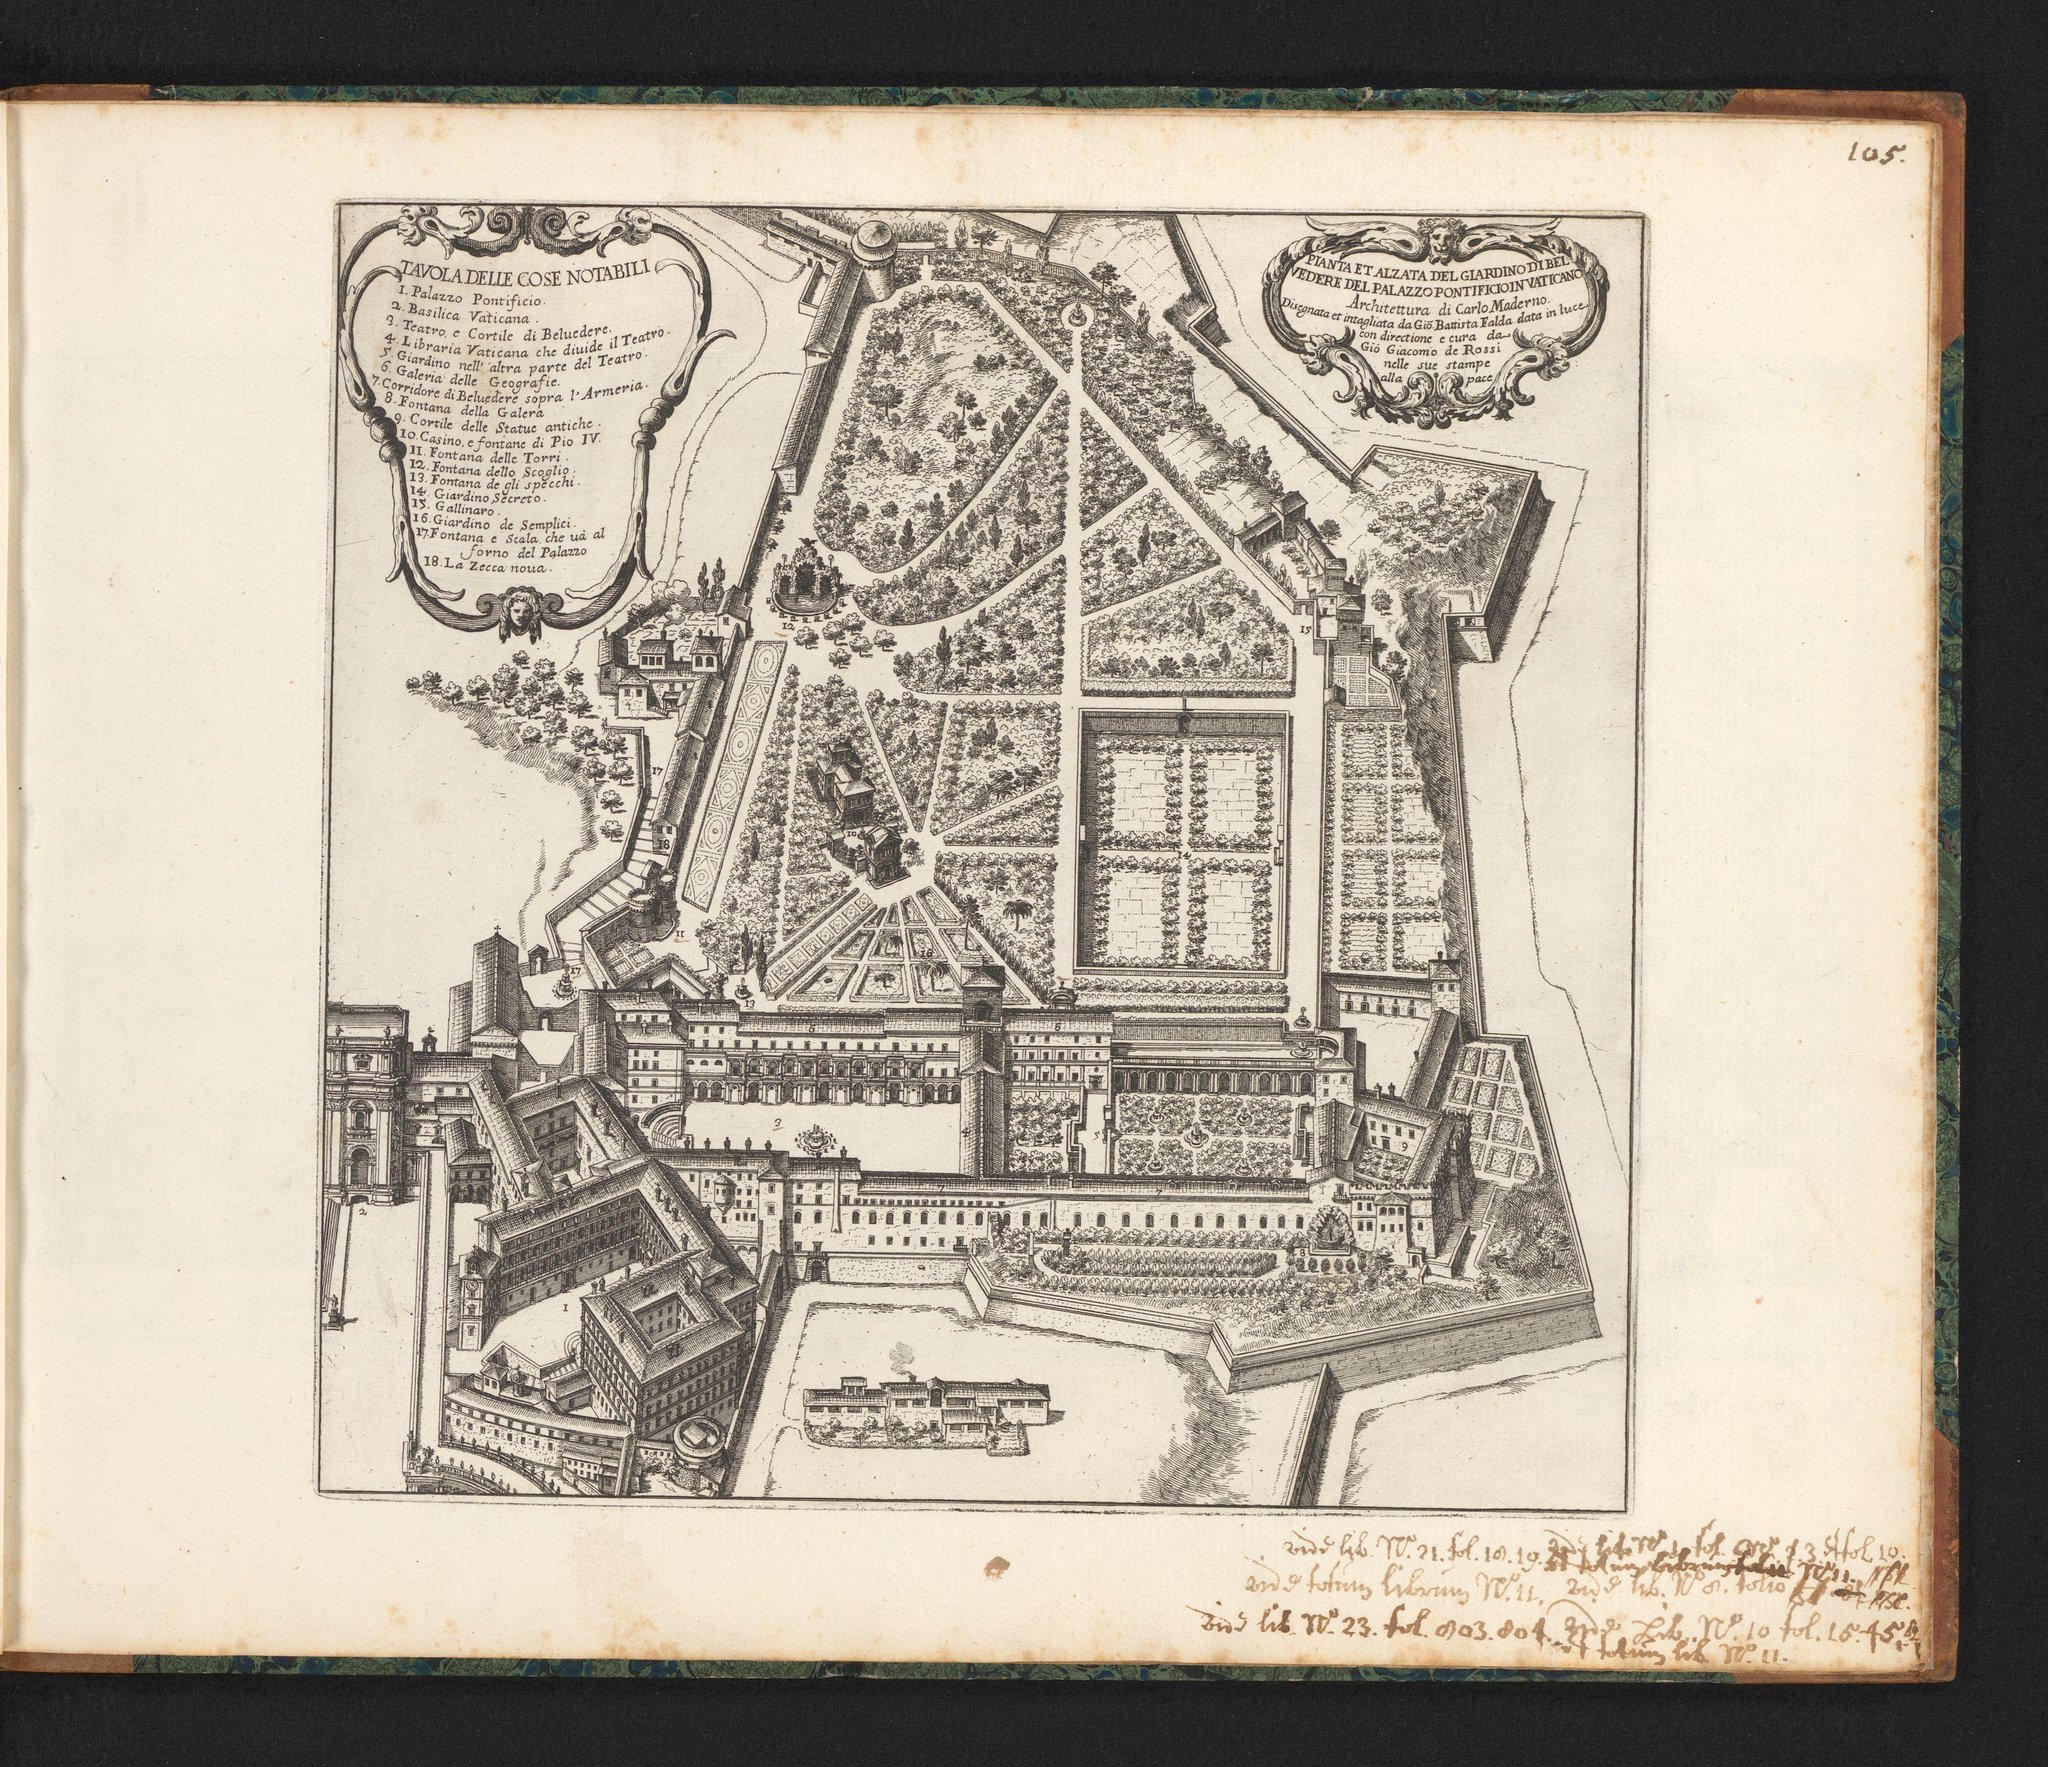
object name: album leaf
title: Tuinen in Rome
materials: paper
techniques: etching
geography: italy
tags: plan, map of garden, garden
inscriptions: inscription: ‘Ende lib. No. 21. fol. 18. 19...’, number: ‘105’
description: Plattegrond van de Vaticaanse Belvedere tuinen. Linksboven een cartouche met een verklarende lijst met nummers. Rechtsboven een cartouche met titel en tekst. Prent maakt deel uit van een album.